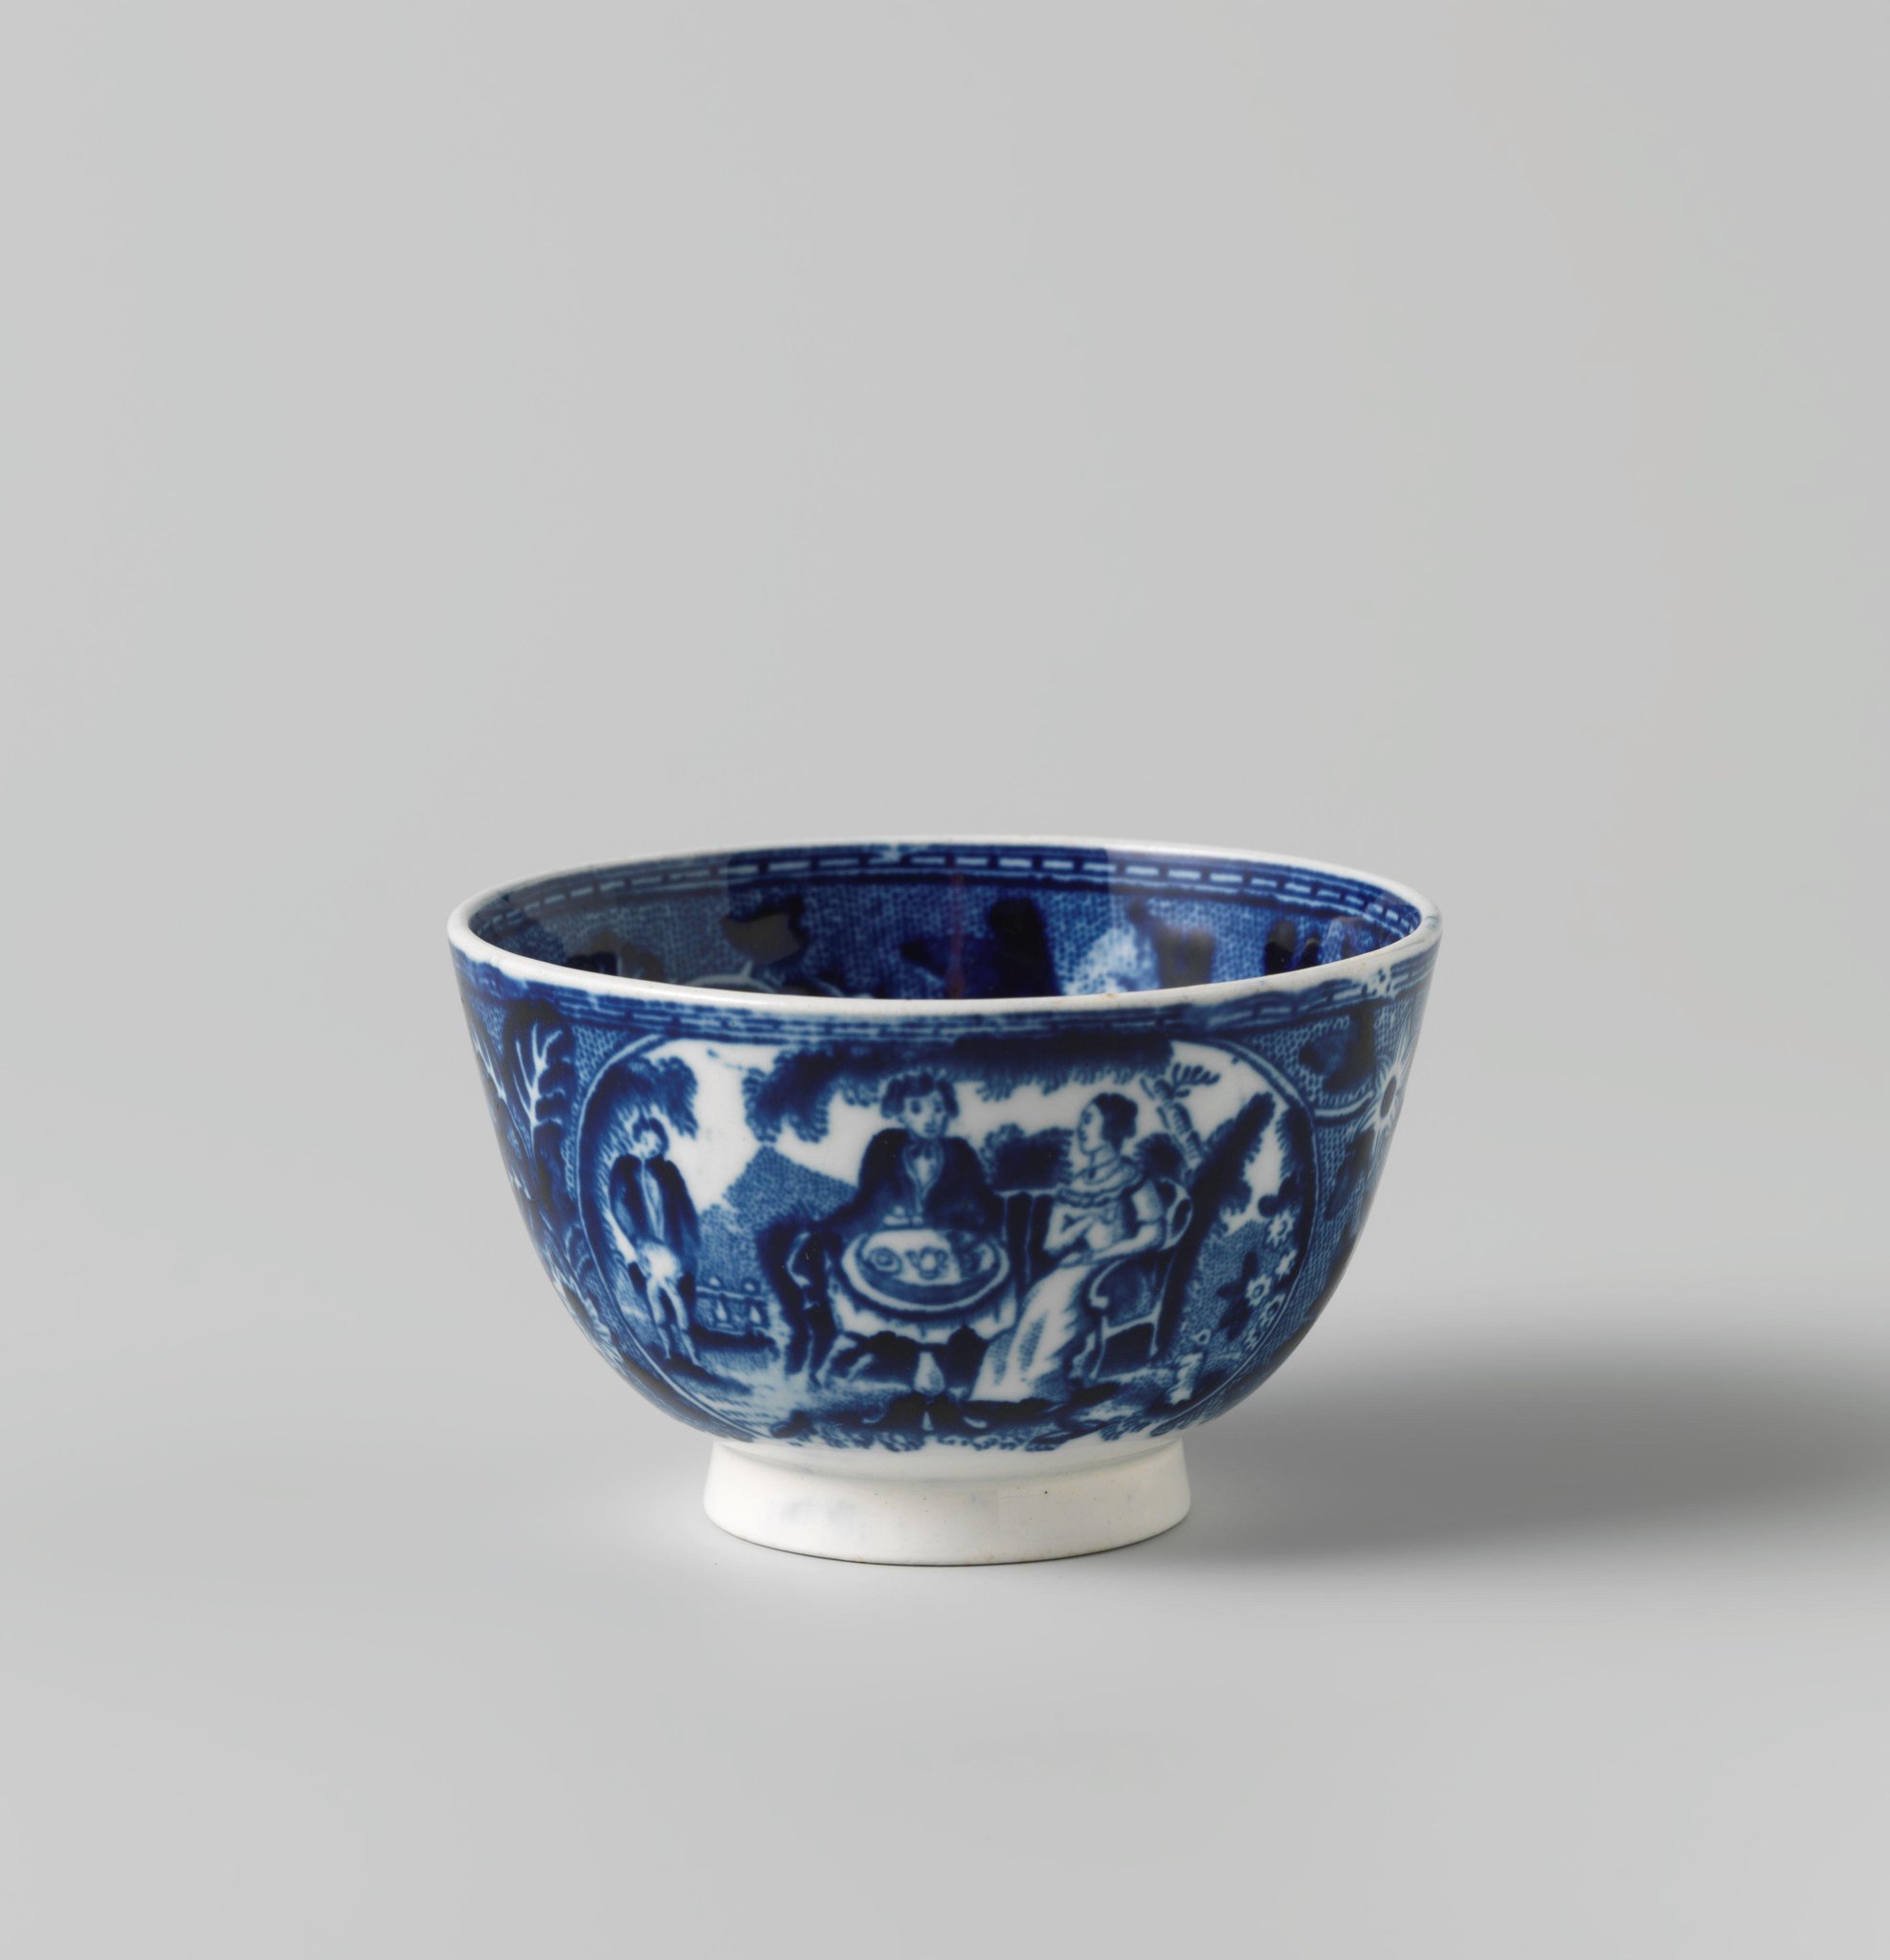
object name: cup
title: Kop zonder oor, met theedrinkend paar en herder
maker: petrus regout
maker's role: plateelbakker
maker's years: 1801-1879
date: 1867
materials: creamware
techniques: transfer decoration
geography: maastricht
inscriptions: mark: ‘4 57’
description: Kom zonder oor van aardewerk met vloeiblauw transferdecor. Aan de buitenkant twee cartouches met een theedrinkend paar en een herder. Tussen de cartouches bloemen. De binnenzijde van de wand is gedecoreerd met bloemen en bladeren. Op de bodem een gestileerde bloem.